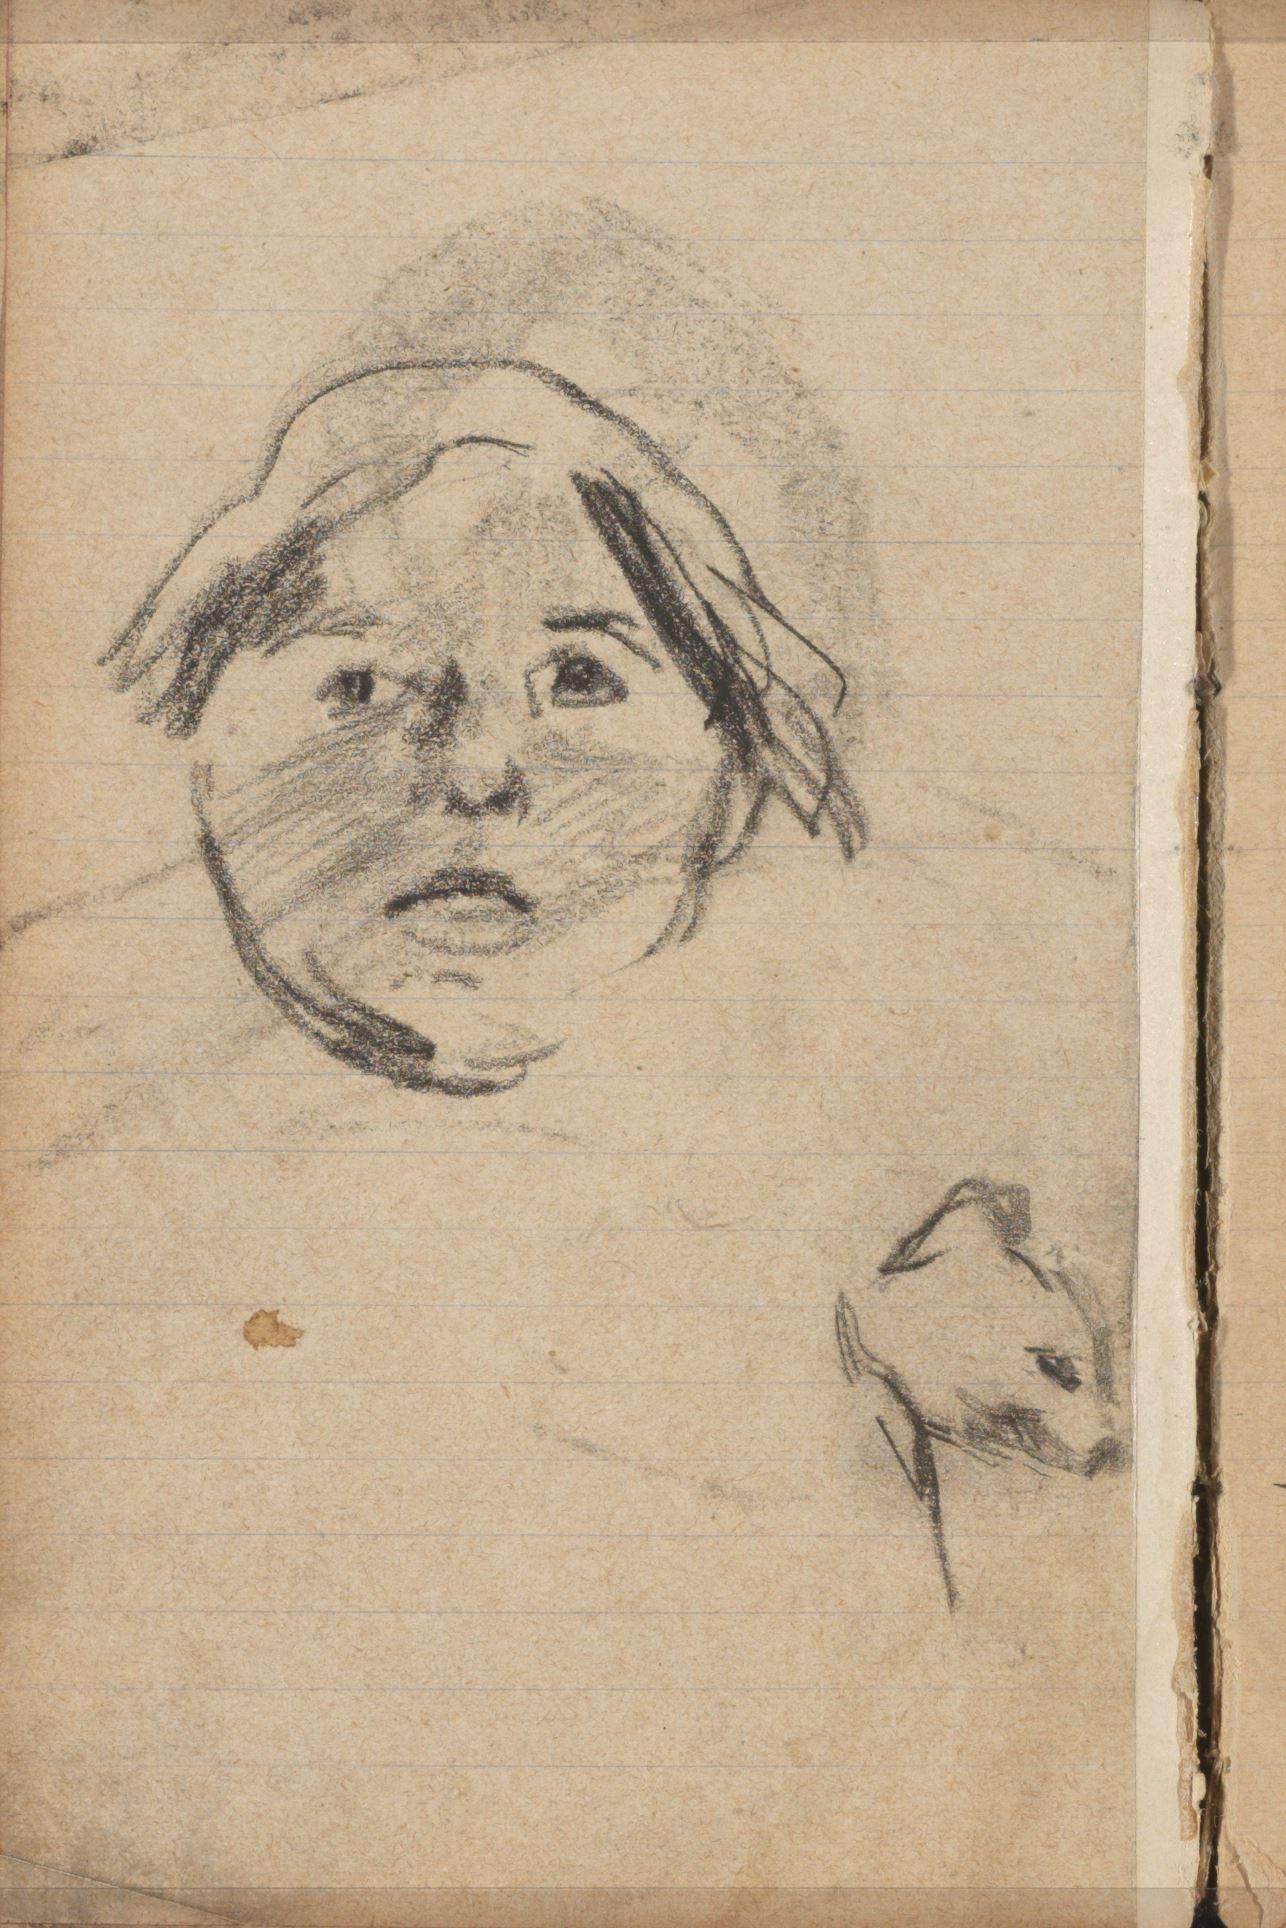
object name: sketchbook leaf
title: Kat en een portret van een onbekende vrouw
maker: george hendrik breitner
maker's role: draughtsman, painter, print maker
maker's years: 1857-1923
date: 1886-1903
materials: chalk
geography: amsterdam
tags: adult woman, cat, anonymous historical person portrayed - bb - woman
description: Pagina 25 uit een schetsboek met 41 bladen.